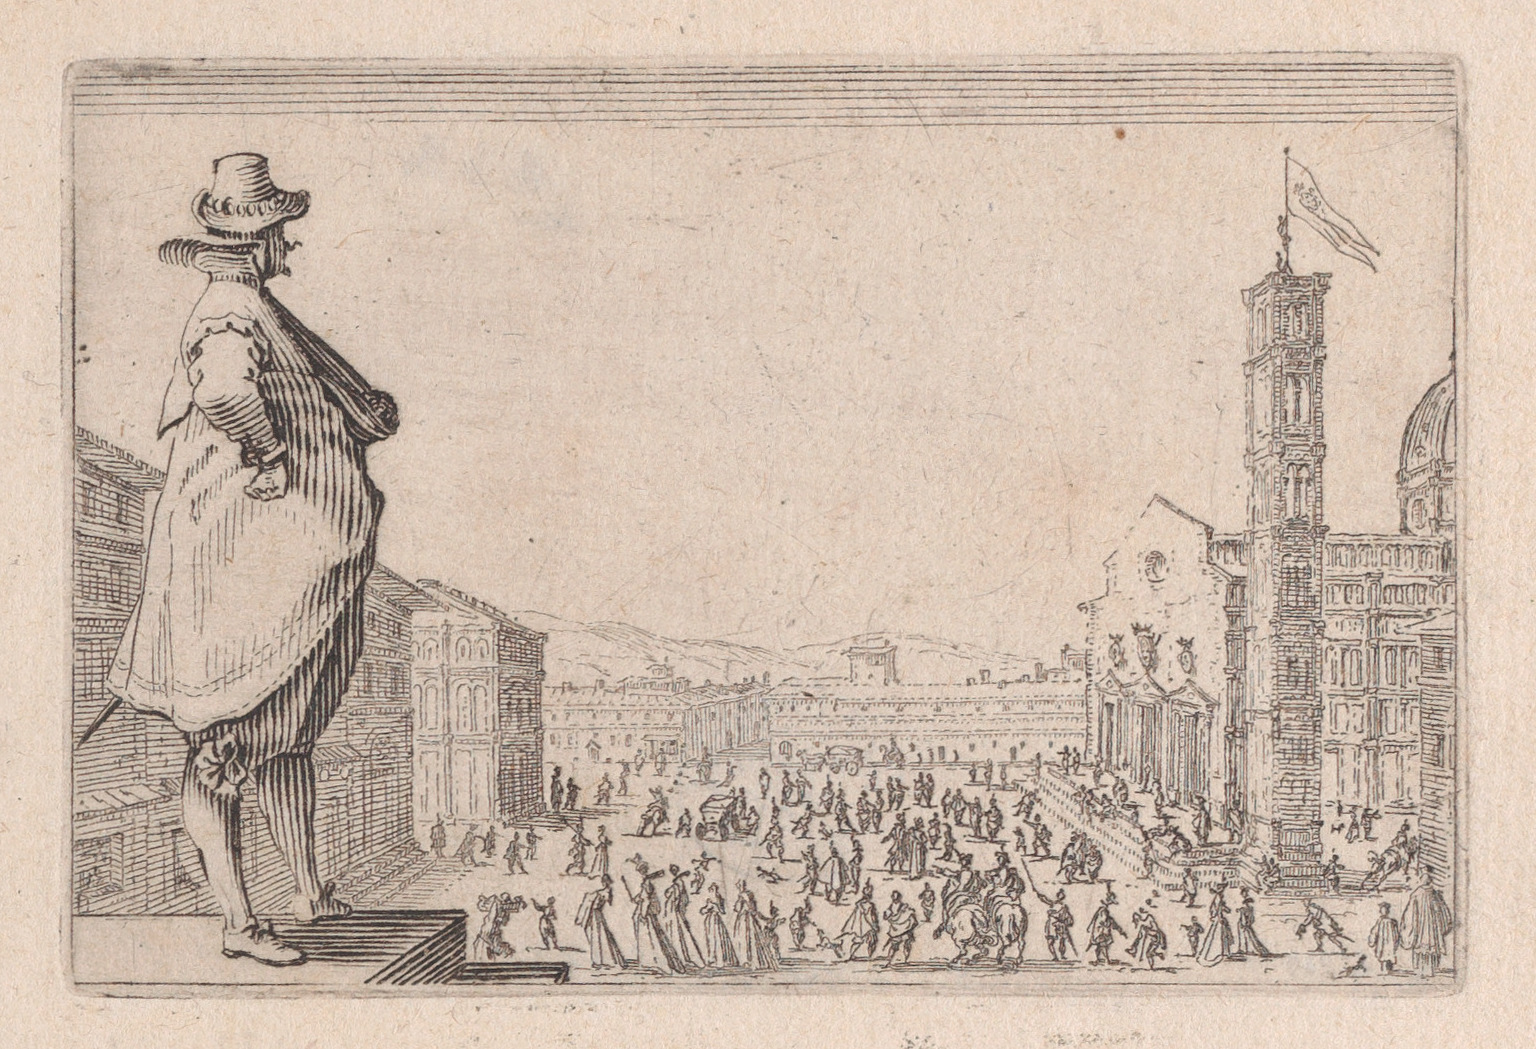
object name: print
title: La Place du Dome, a Florence (The Piazza del Duomo, in Florence), from "Les Caprices" Series B, The Nancy Set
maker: jacques callot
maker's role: artist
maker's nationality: french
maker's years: 1592-1635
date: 1617-1620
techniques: etching